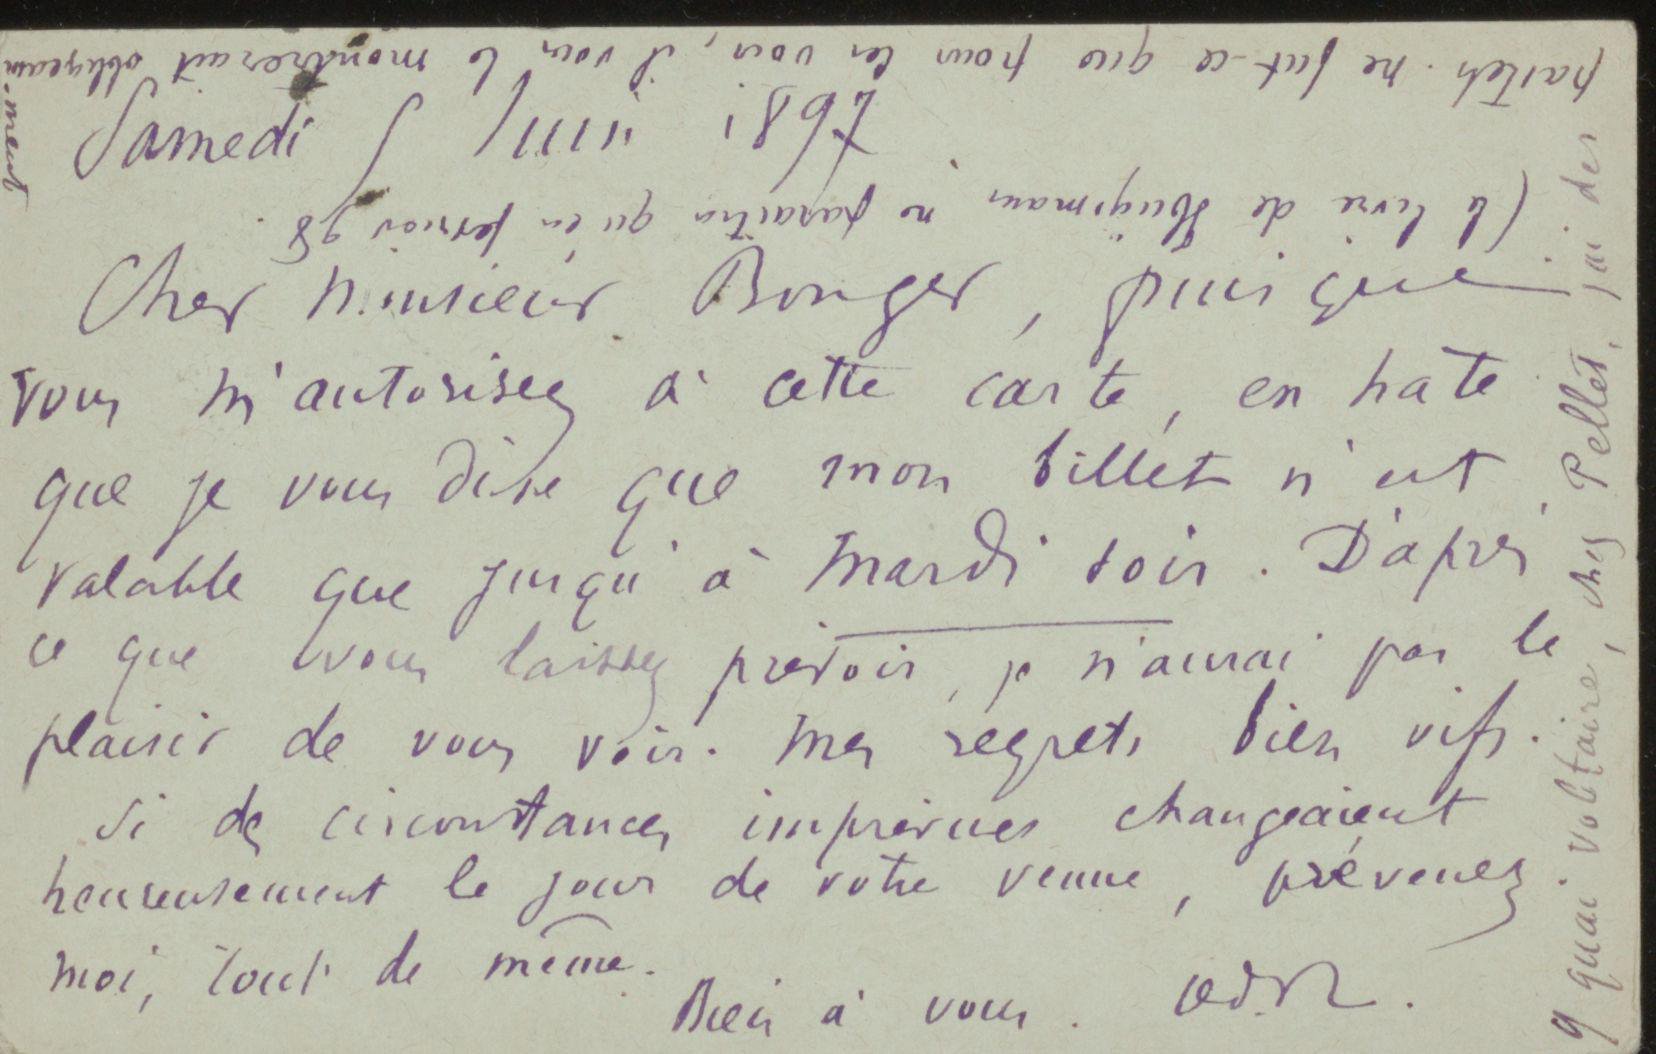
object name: postcard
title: Briefkaart aan Andries Bonger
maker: odilon redon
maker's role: draughtsman, painter, print maker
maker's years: 1840-1916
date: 1897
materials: cardboard, ink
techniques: pen, writing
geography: paris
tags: amsterdam, andries bonger, publisher, gustave pellet, art trade, art shop, drawing, paris